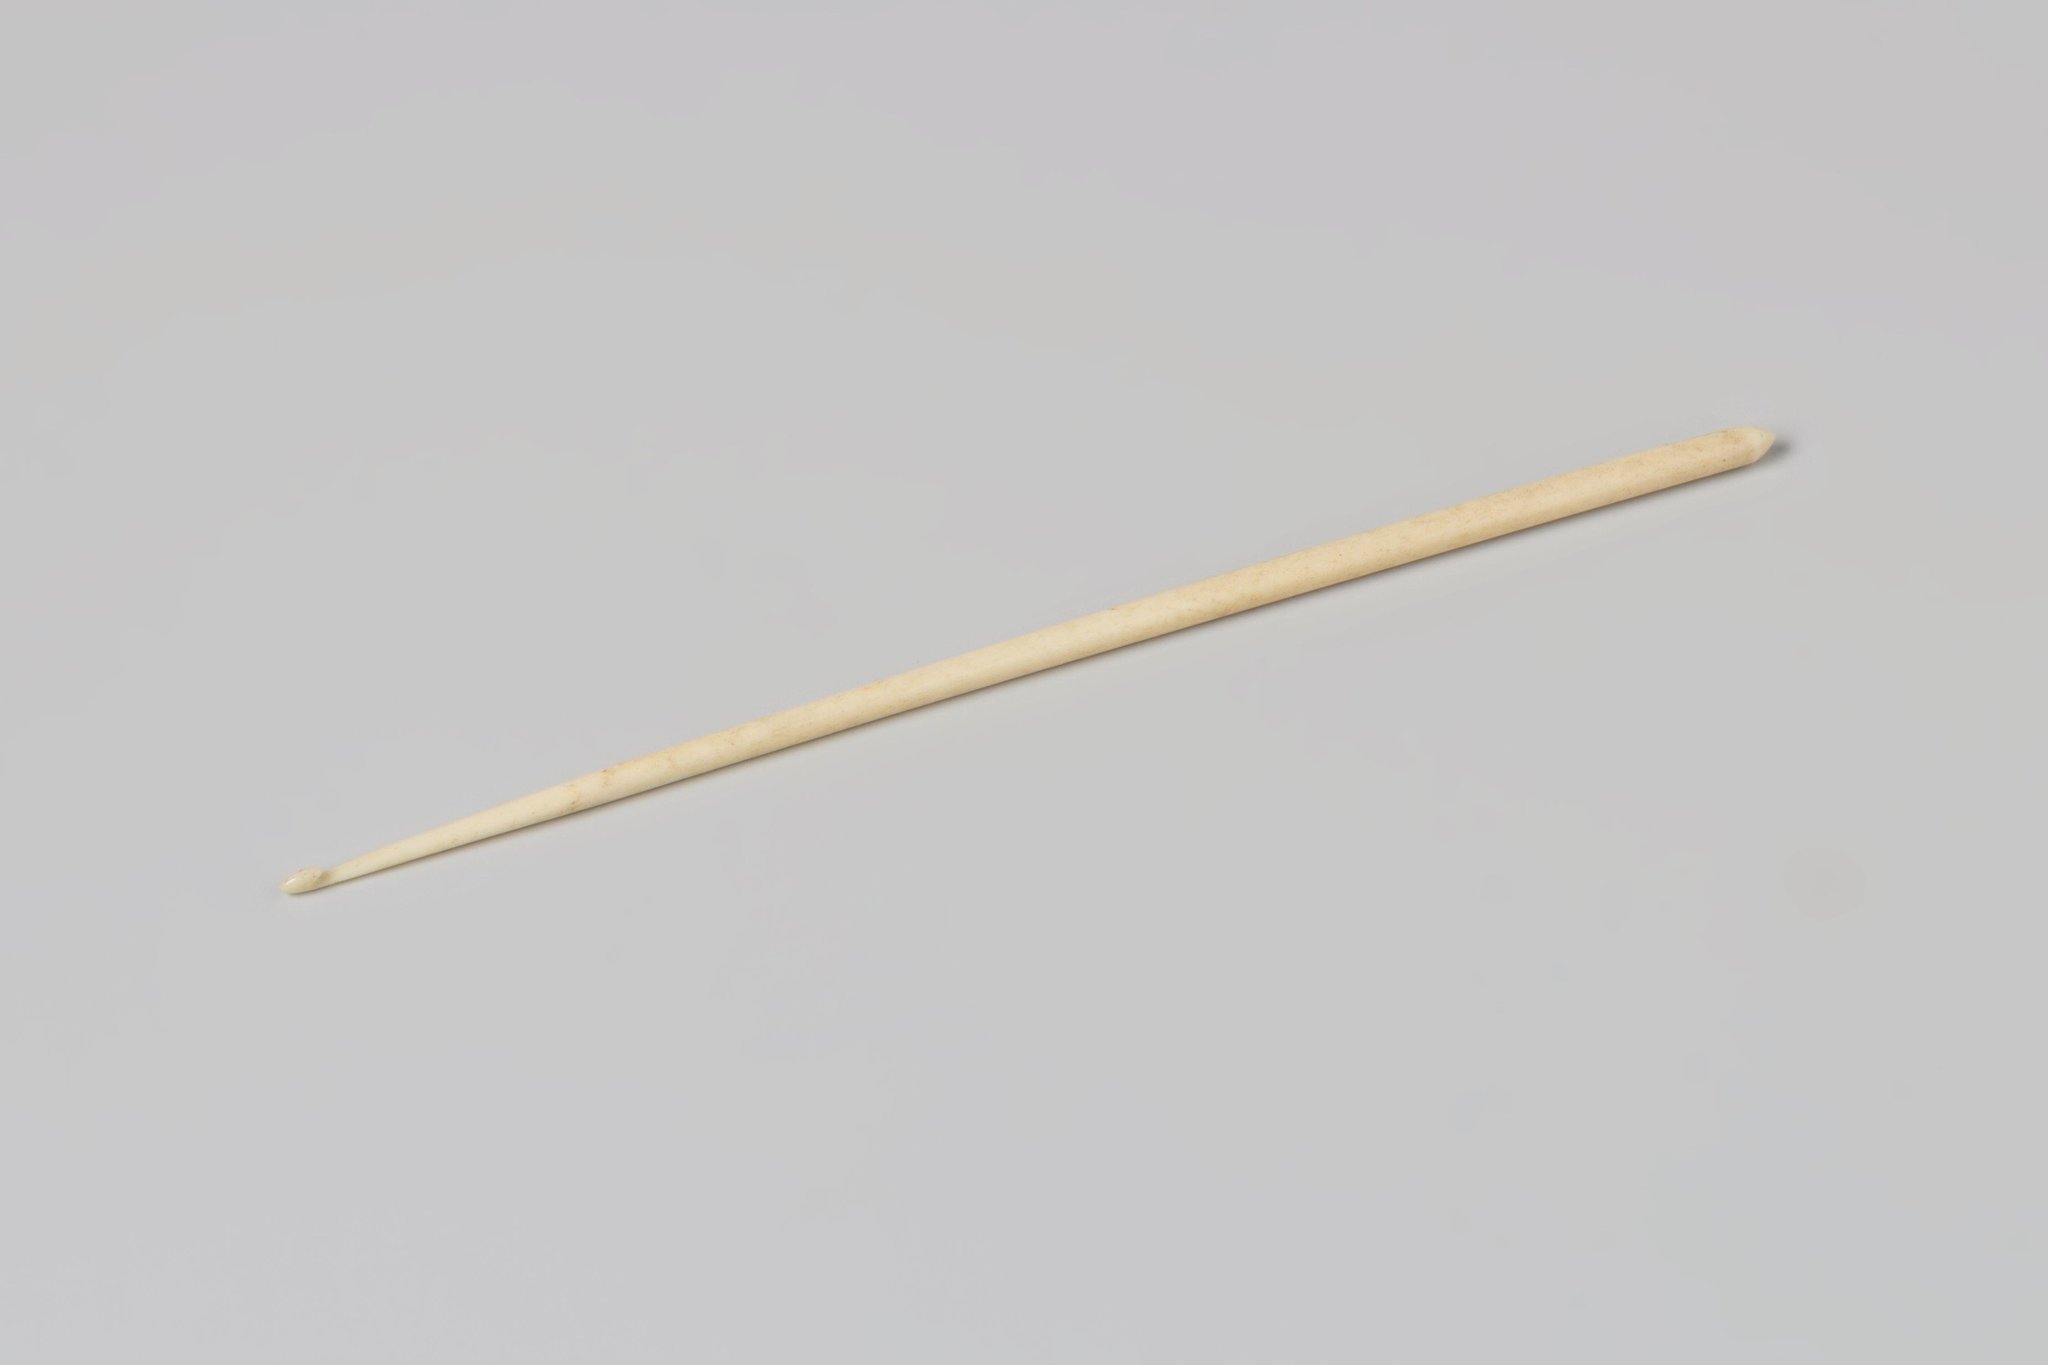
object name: haaknaald, haakpen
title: Haakpen van witte kunststof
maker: Anonymous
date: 1900-1950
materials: plastic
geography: england